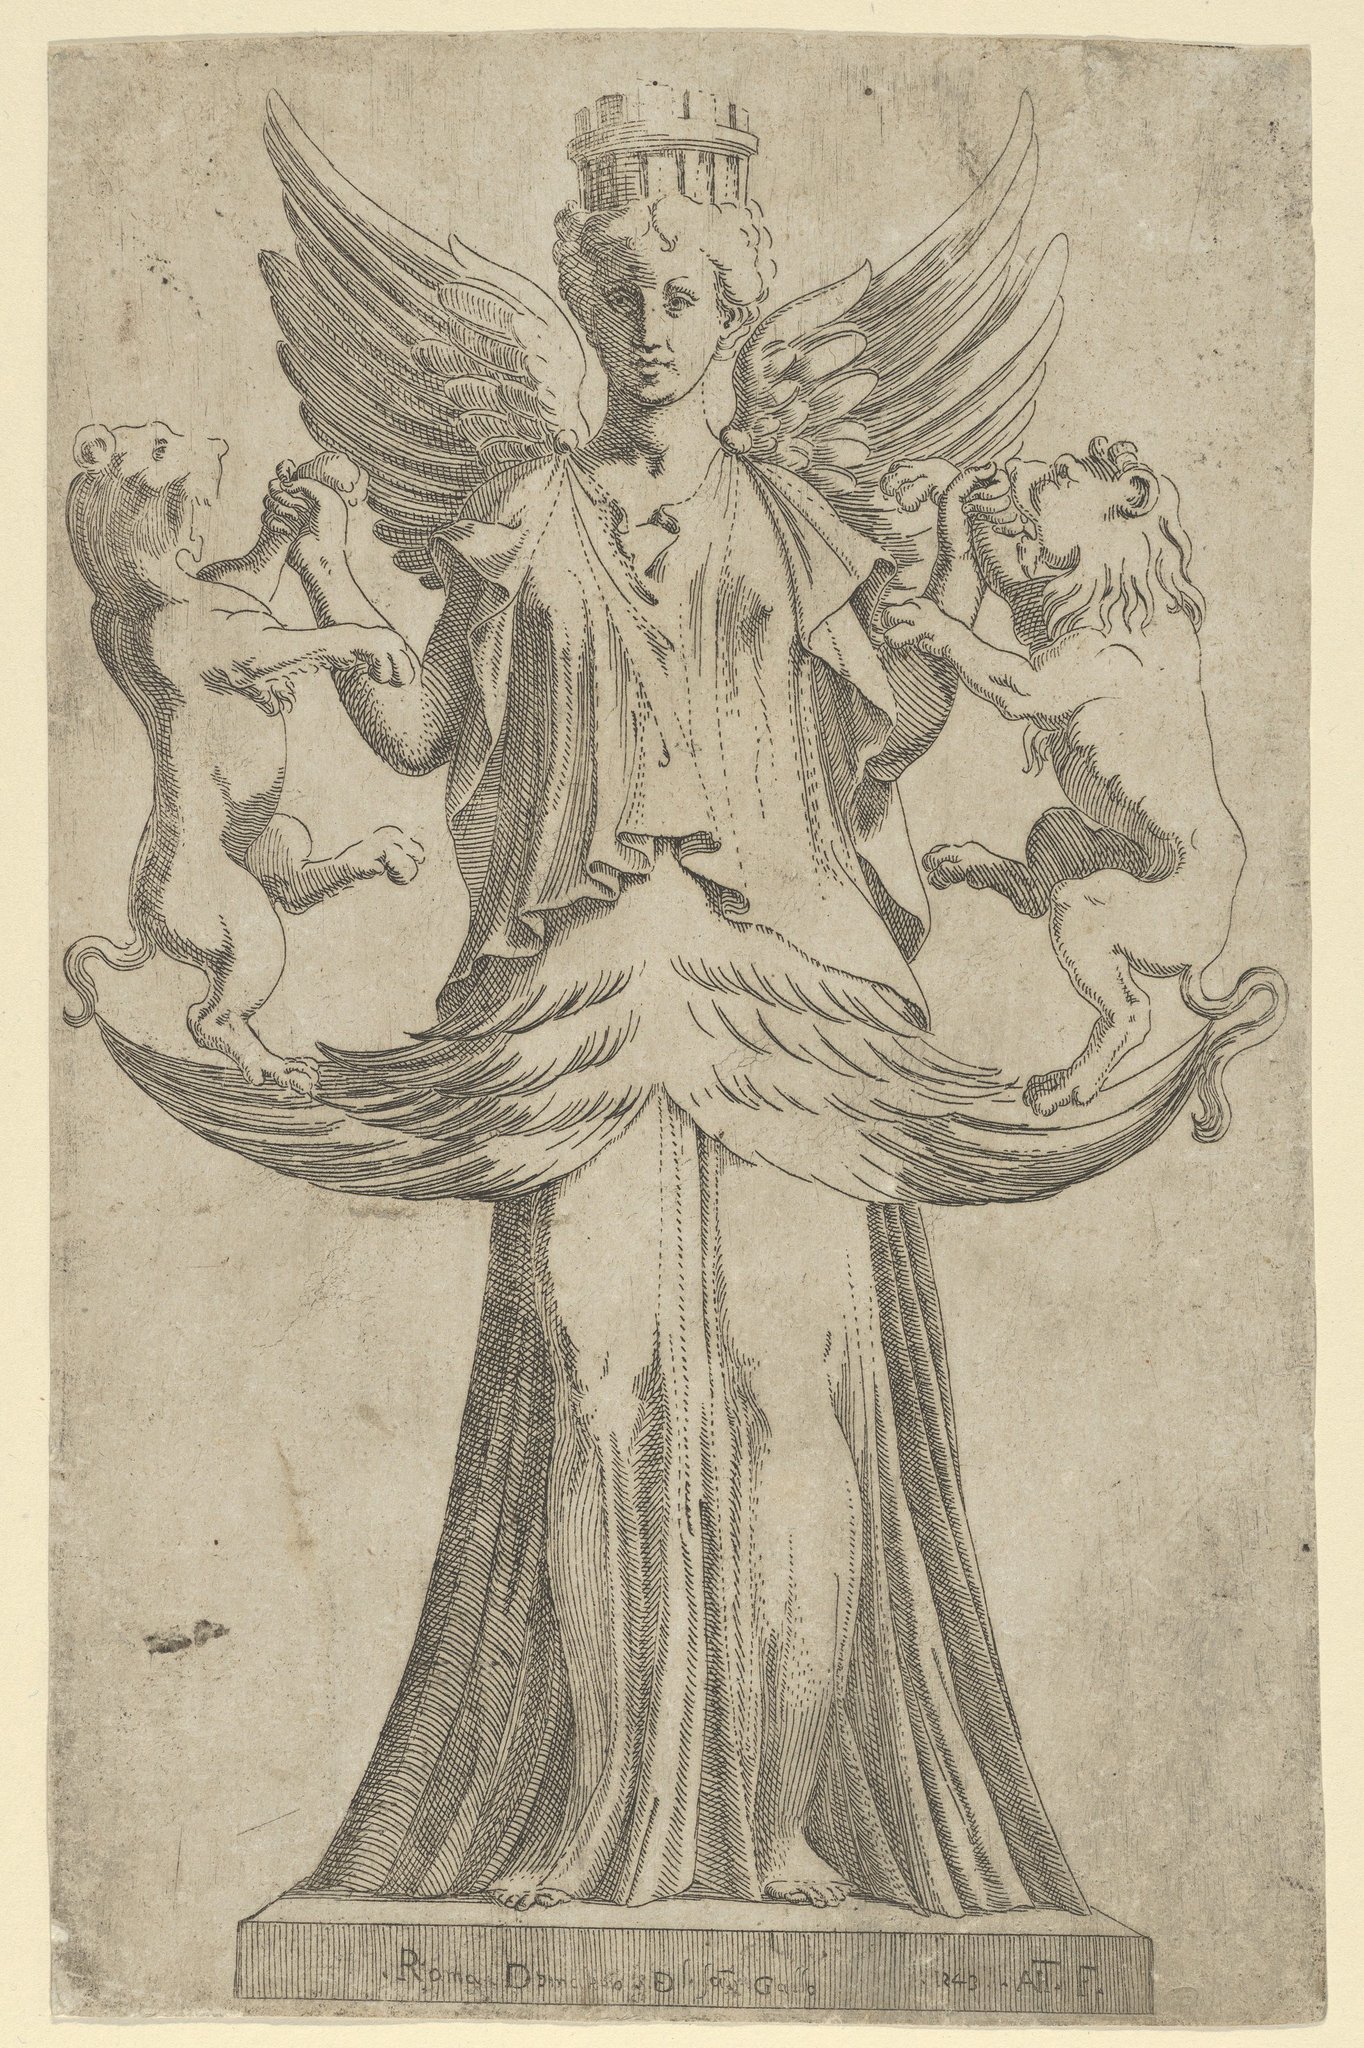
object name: print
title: Cybele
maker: antonio fantuzzi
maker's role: artist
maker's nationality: italian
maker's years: 1537-1545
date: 1543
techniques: etching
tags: lions,goddess